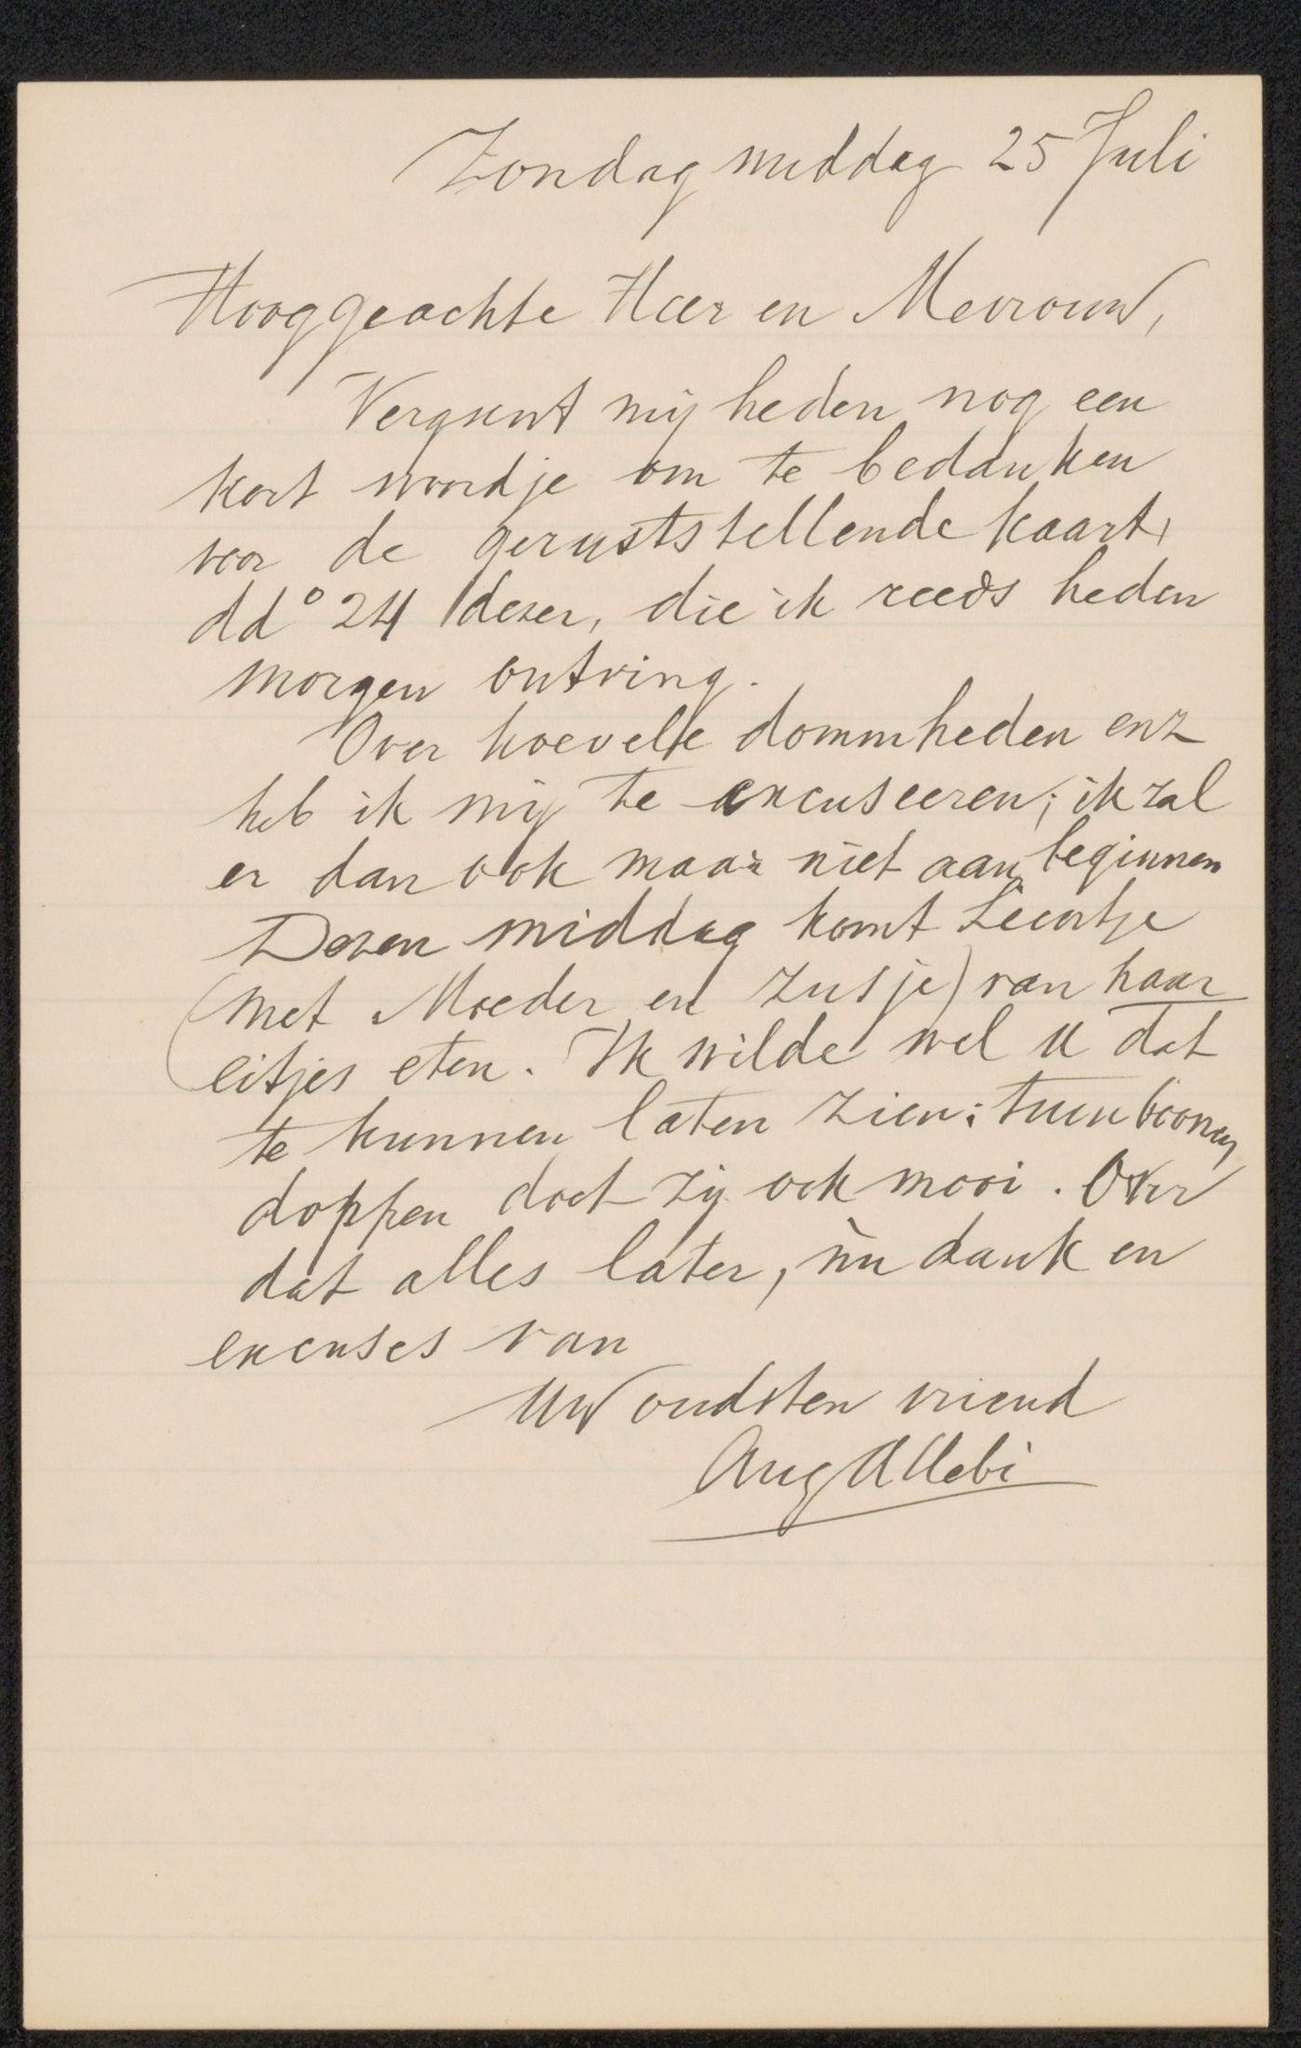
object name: letter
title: Brief aan Max Wilhelm Carl Weber en Anne Antoinette Weber-Van Bosse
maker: august allebé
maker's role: draughtsman, print maker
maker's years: 1838-1927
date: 1862-1927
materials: ink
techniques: pen, writing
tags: anne antoinette weber-van bosse, leiden, print maker, rembrandt van rijn, anne mankes-zernike, amsterdam, painter, draughtsman, travelling; tourism, switzerland